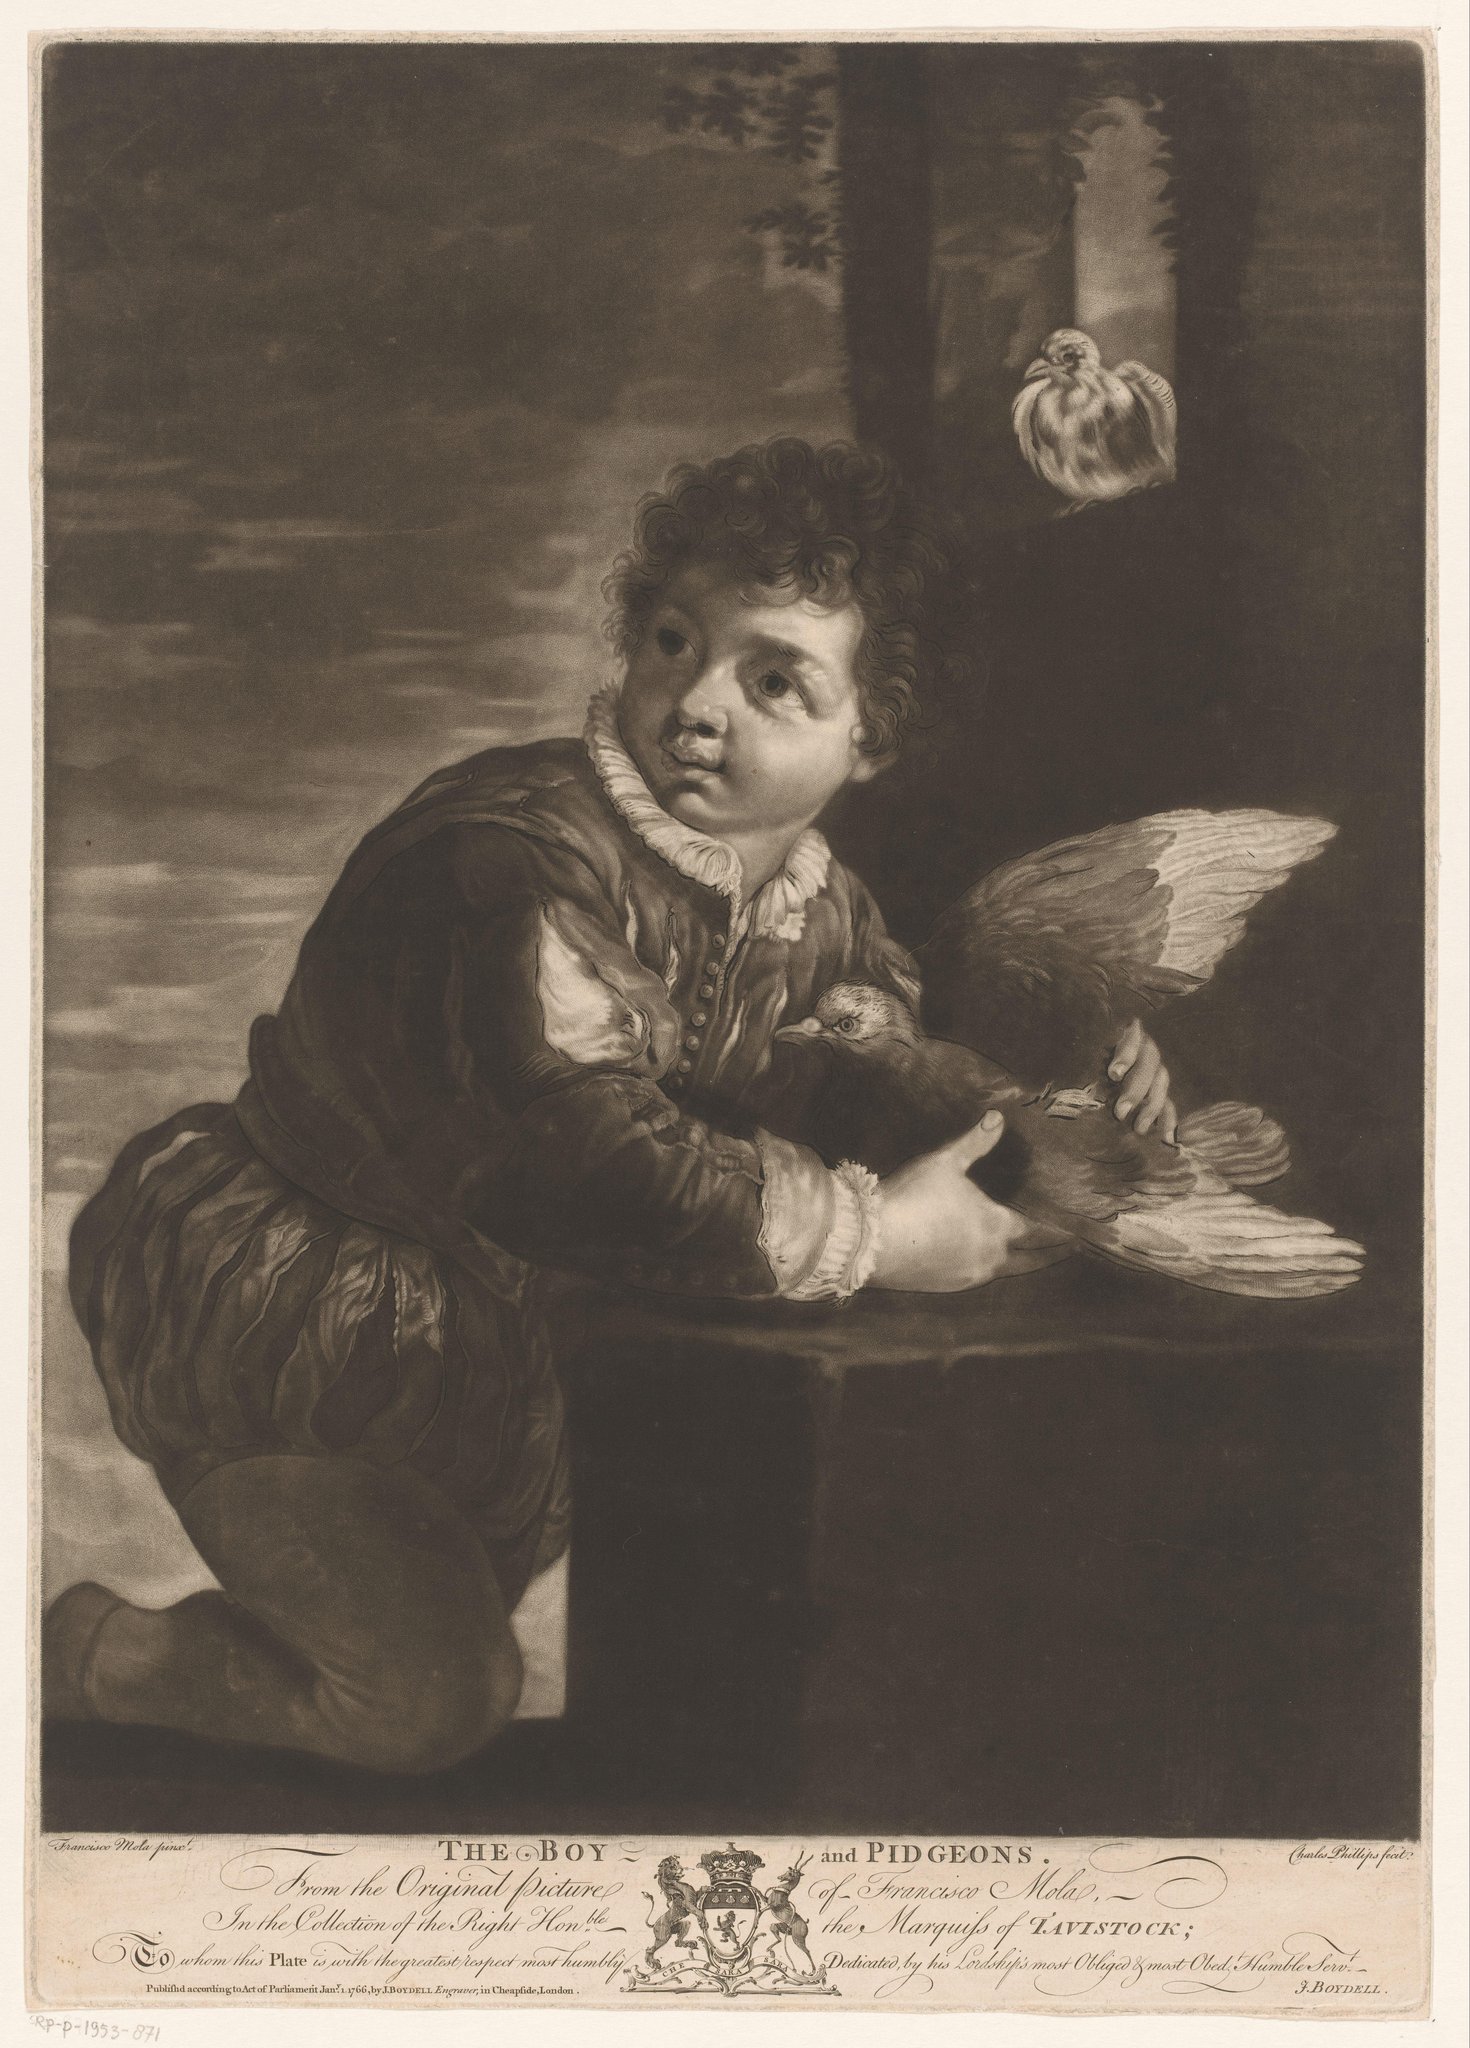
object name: print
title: The Boy and Pidgeons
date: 1766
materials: paper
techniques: etching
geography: london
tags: boy (child between toddler and youth), doves, pigeons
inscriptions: collector's mark: Lugt 2228, collector's mark: Lugt 2760